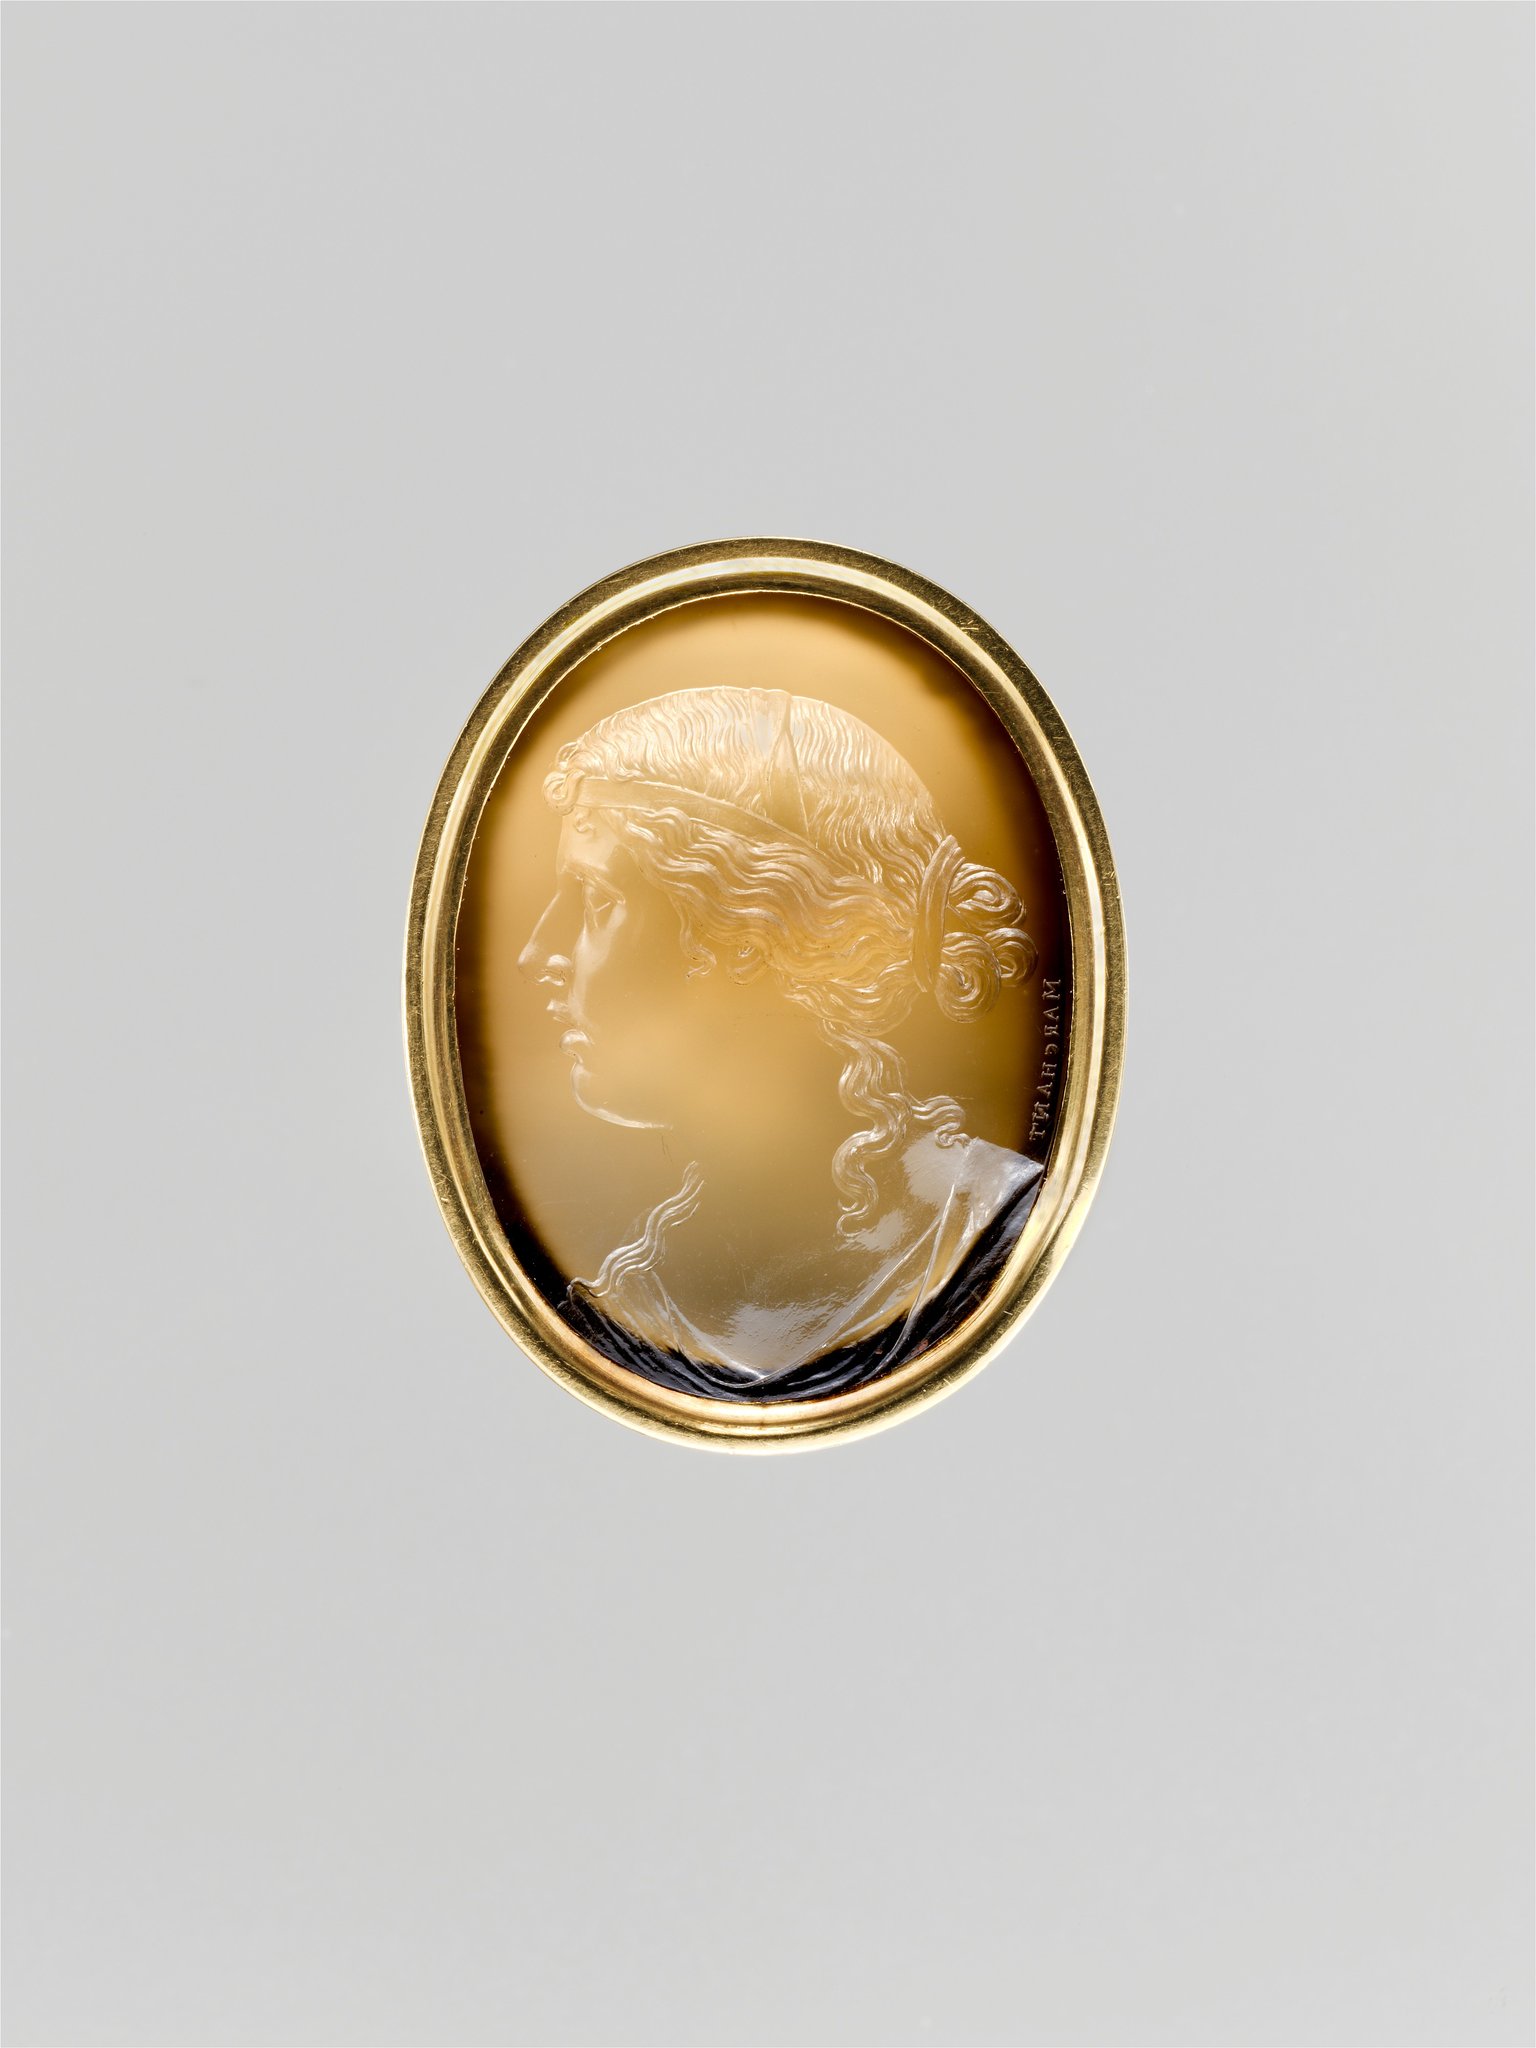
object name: intaglio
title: Portrait of Emma Hart, Later Lady Hamilton (1765–1803)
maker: nathaniel marchant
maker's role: artist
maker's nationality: british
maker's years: 1739-1816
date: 1786-1787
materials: stone, silver gilt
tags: profiles,women